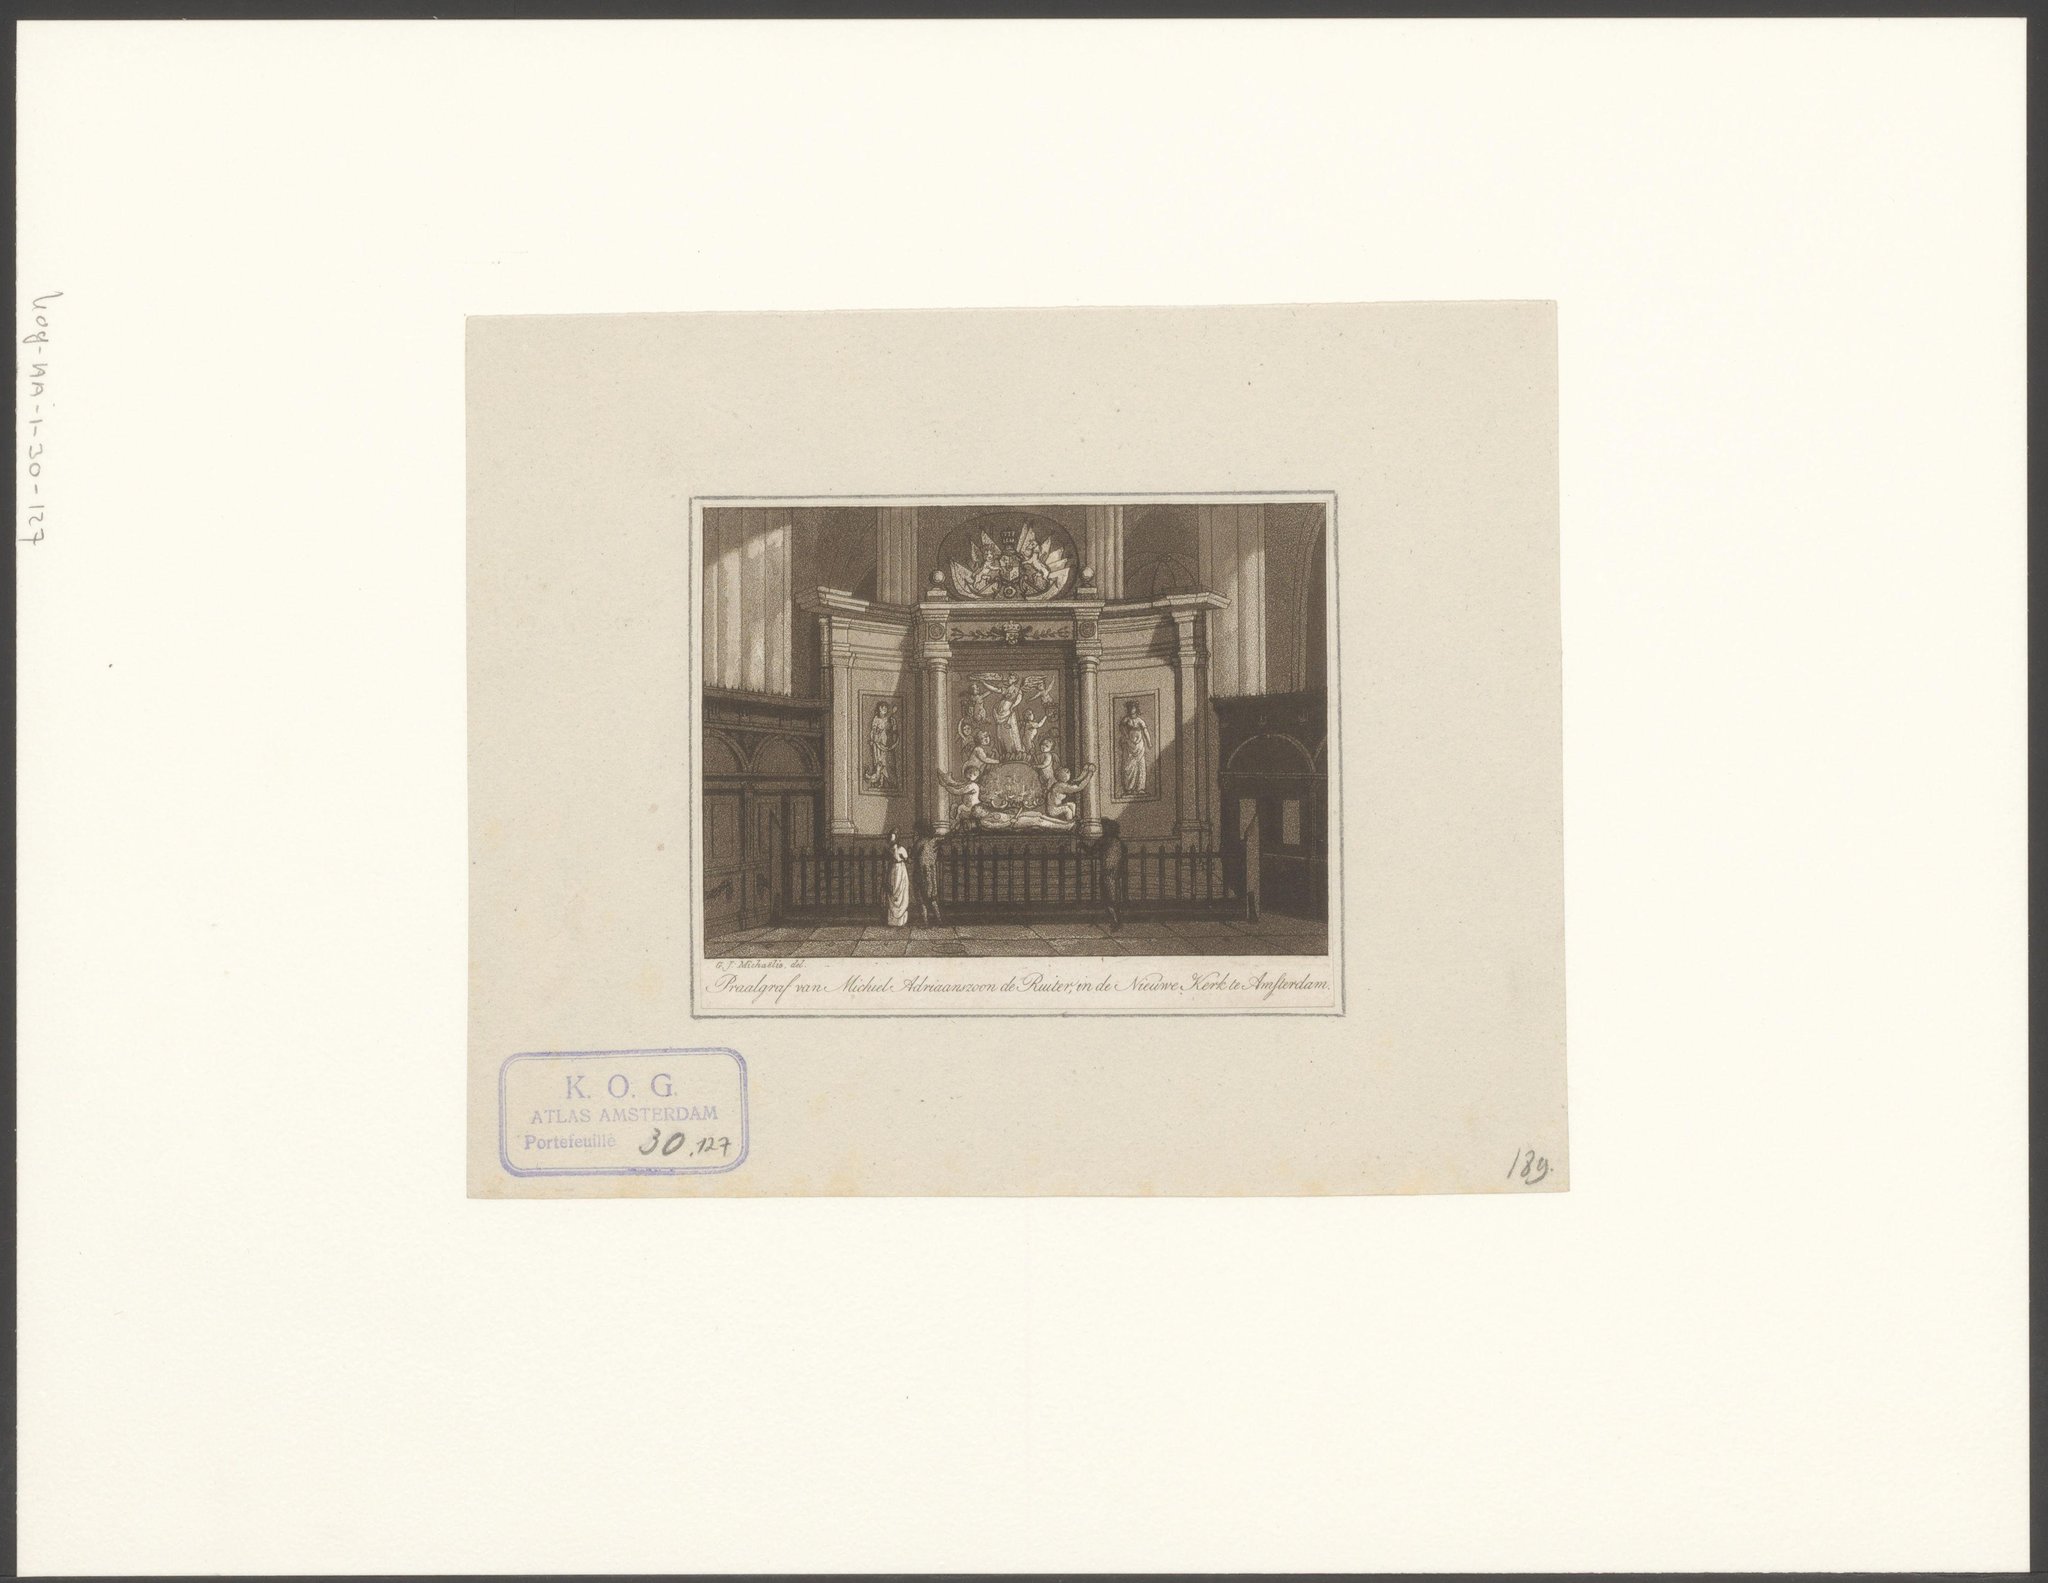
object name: print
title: Praalgraf van Michiel Adriaanszoon de Ruiter, in de Nieuwe Kerk te Amsterdam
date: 1813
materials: paper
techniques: aquatint, engraving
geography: northern netherlands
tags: michiel adriaenszoon de ruyter, grave-building, monumental tomb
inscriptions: collector's mark: Lugt 1641b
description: Prent mogelijk uit: Reis door Holland in de Jaren 1807-1812. 3 dln. Amsterdam: Evert Maaskamp, [1813], dl. 1.